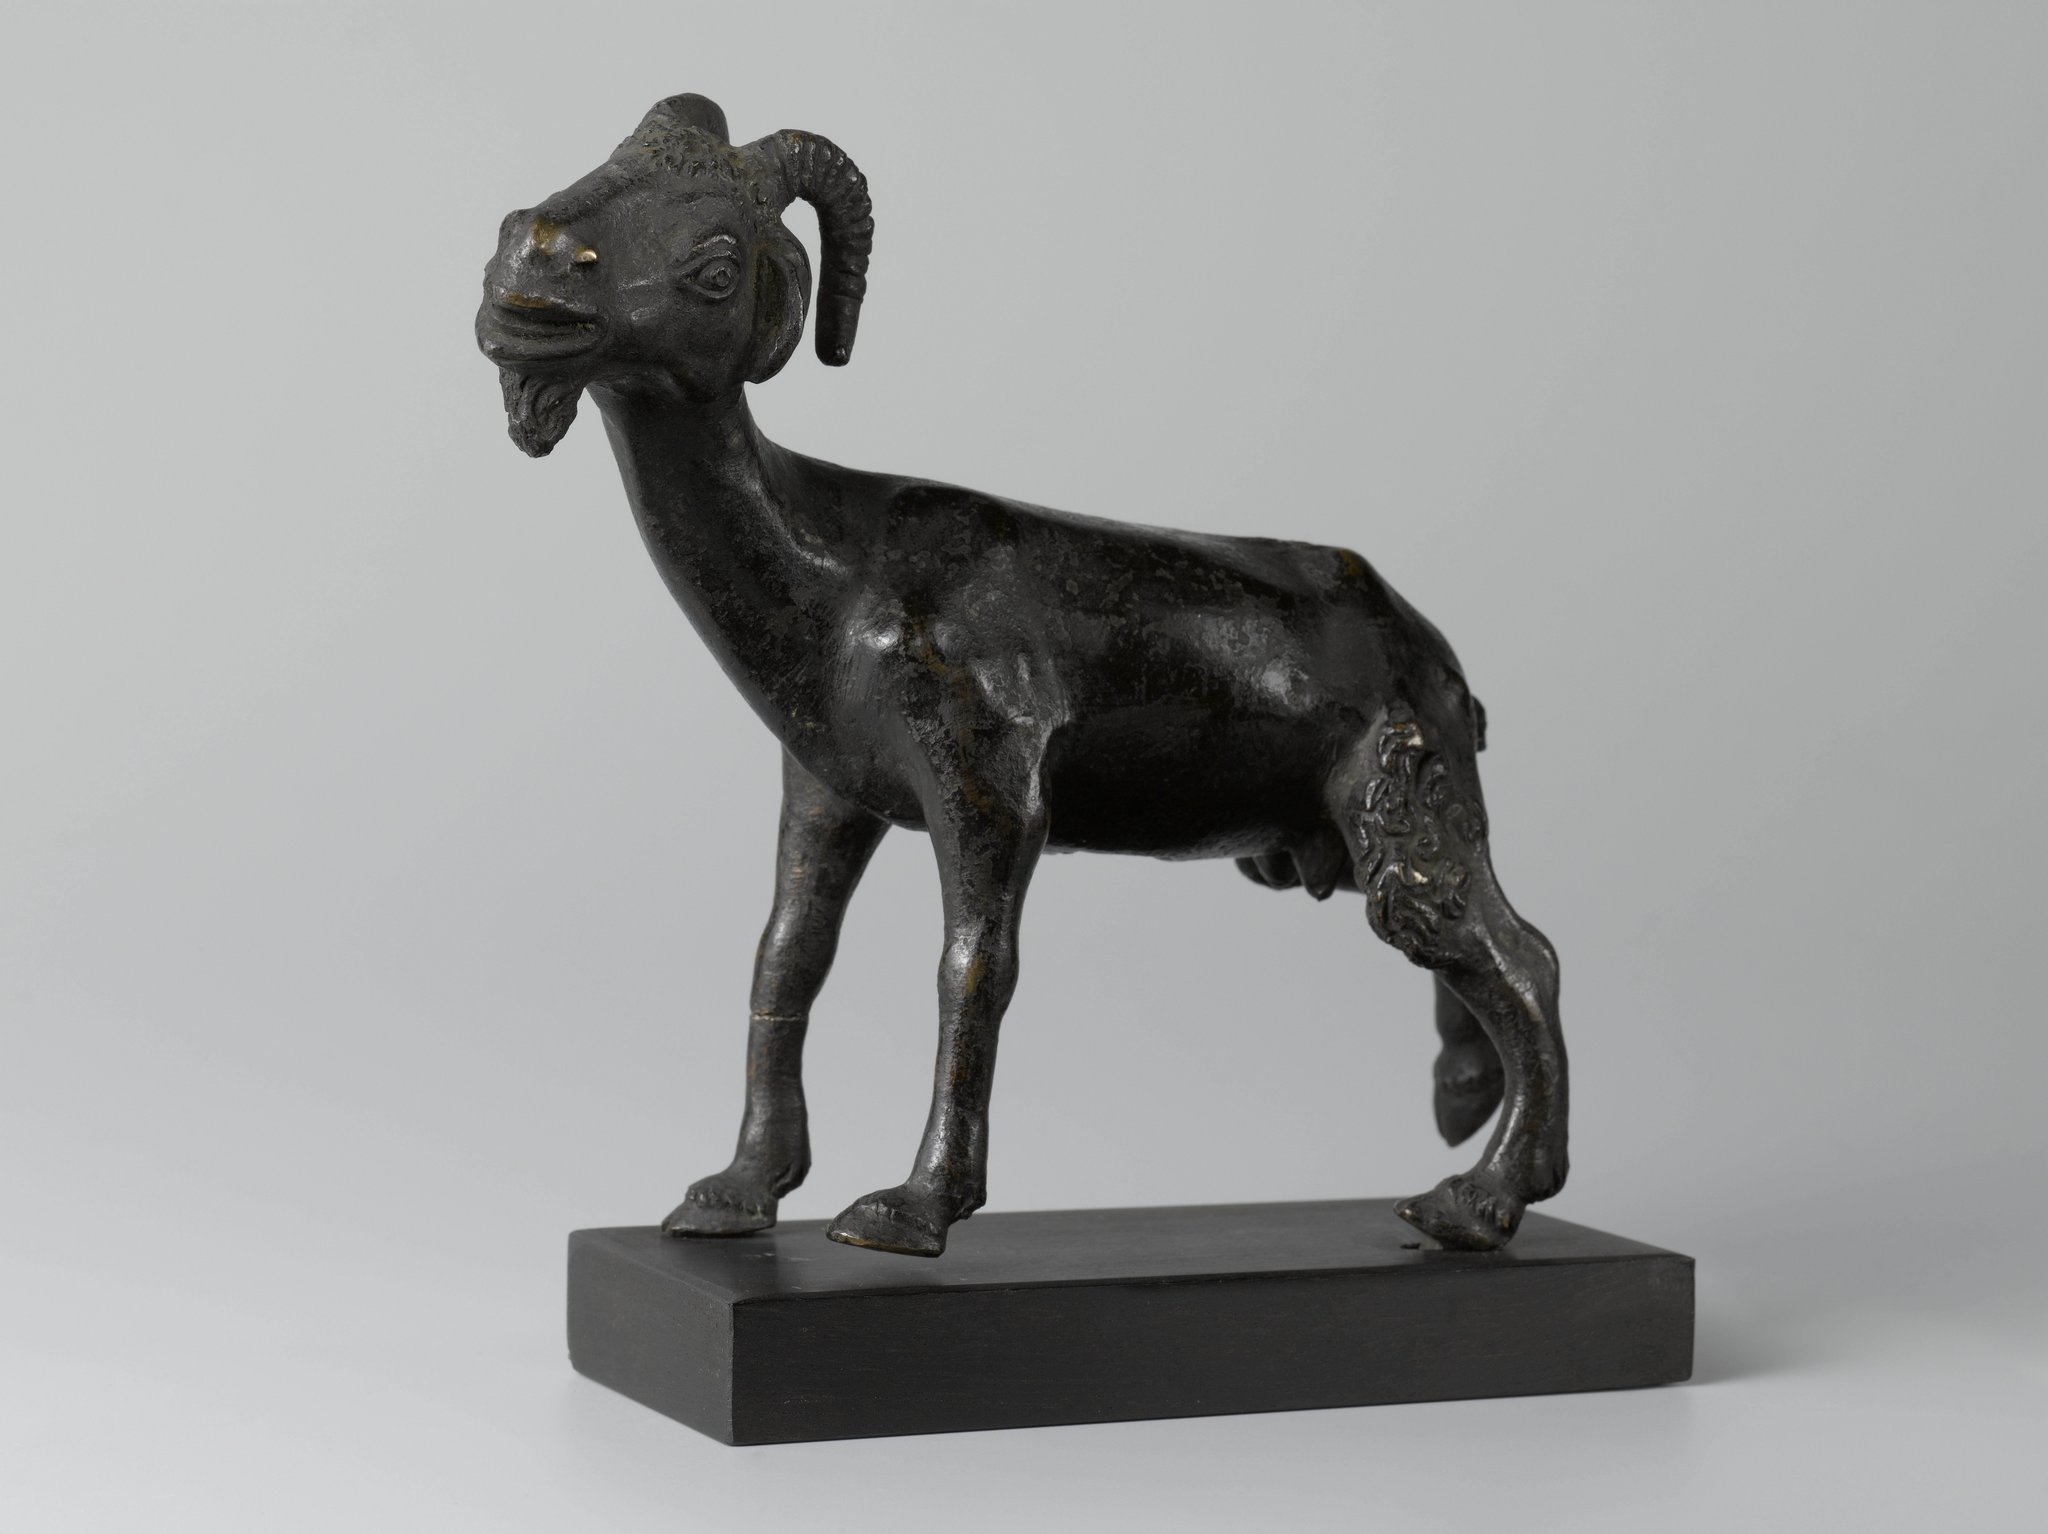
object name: sculpture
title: Geit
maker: Anonymous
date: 1520-1550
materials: bronze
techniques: patinaed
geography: padua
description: Goat. Bronze. Padua, c. 1520 - 1550.